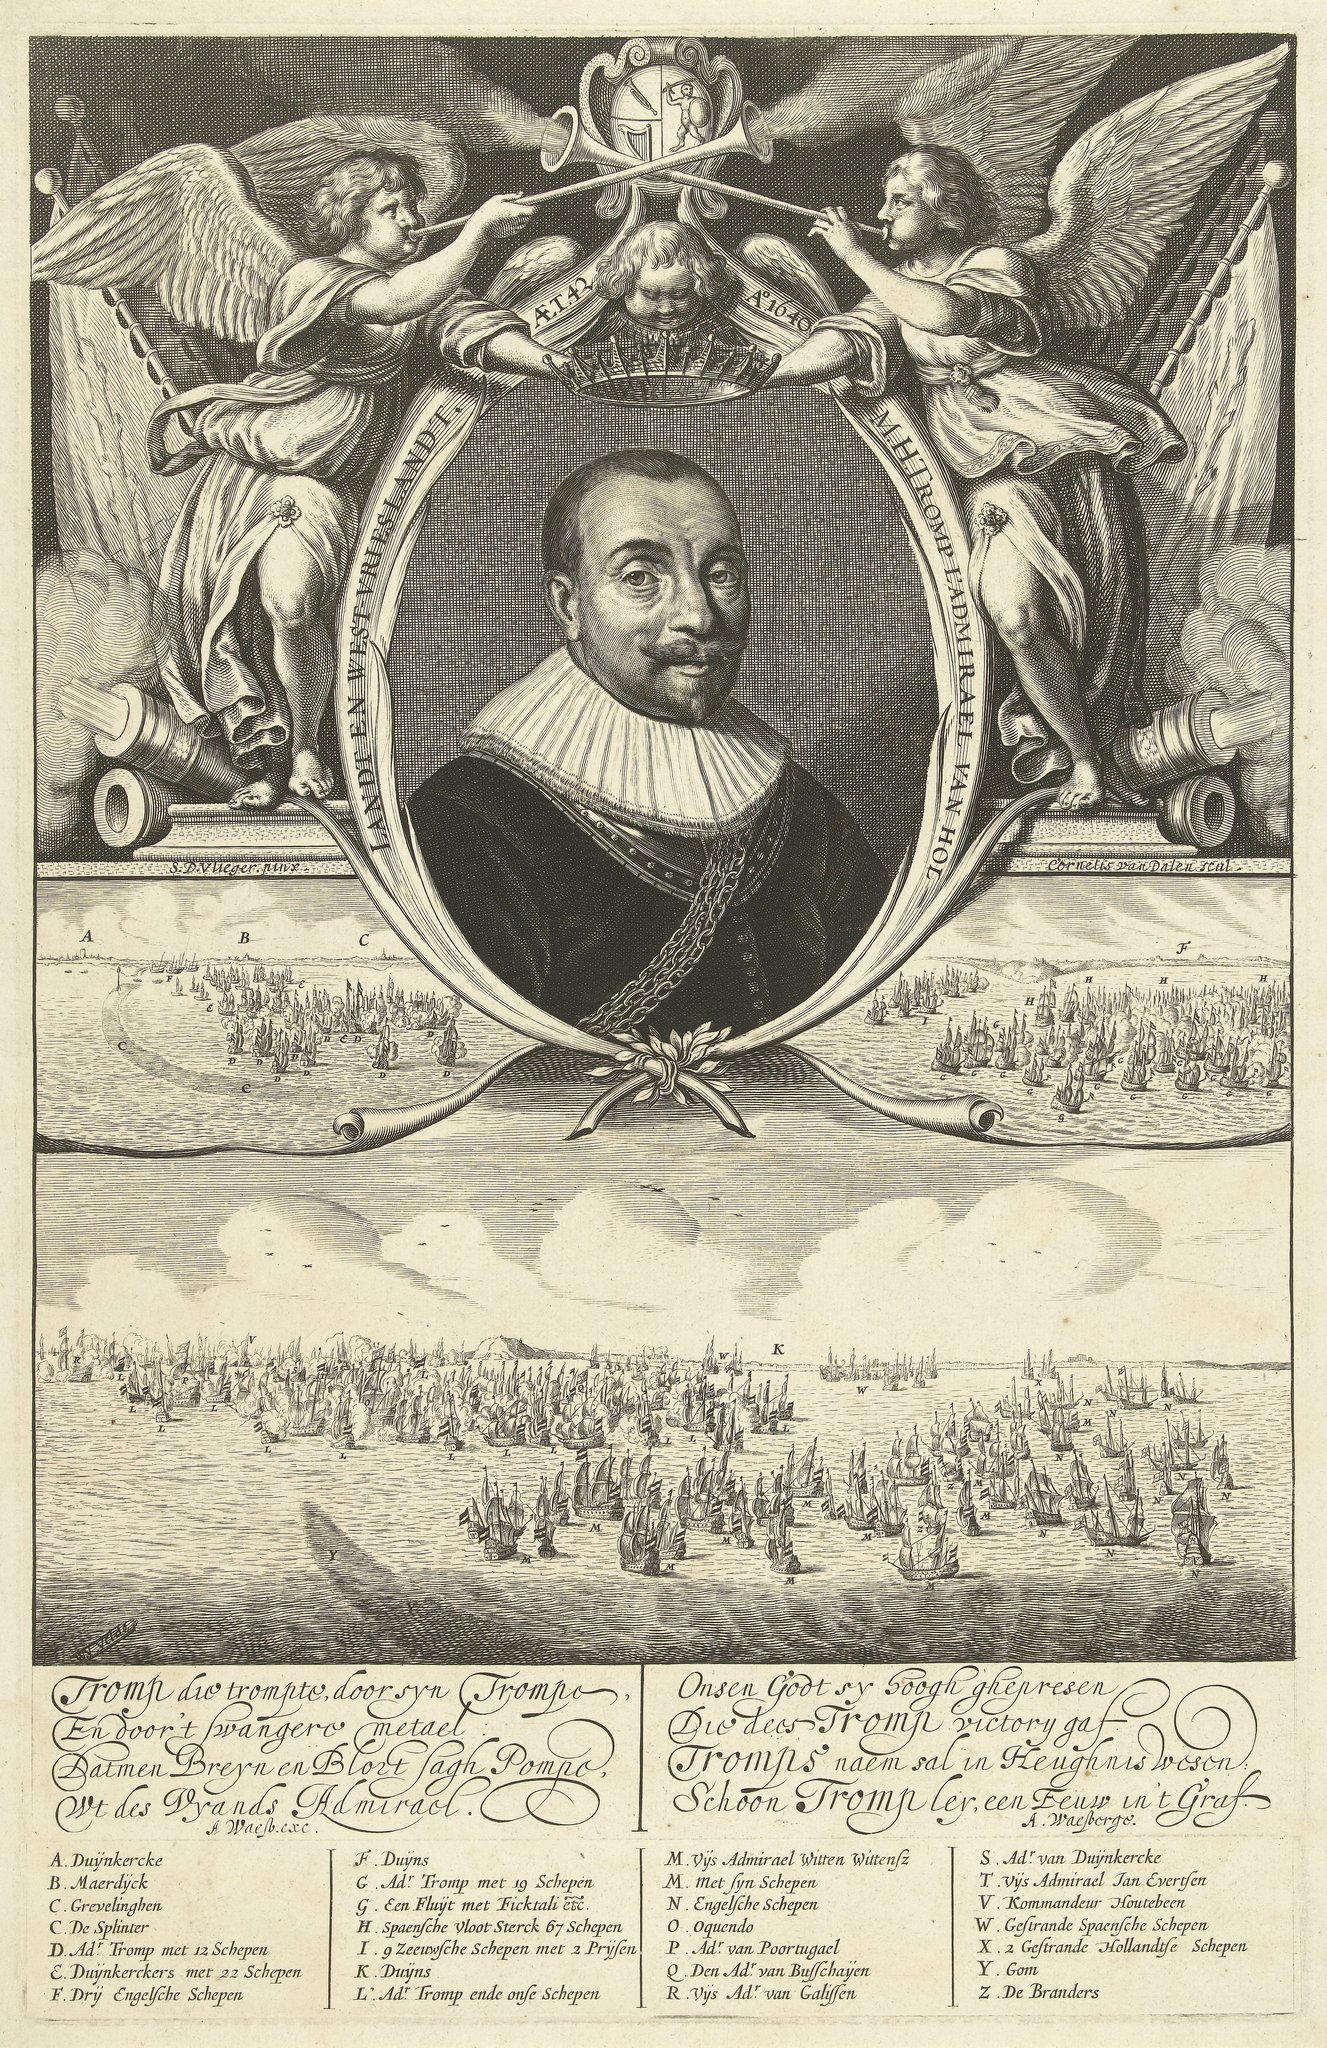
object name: print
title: M.H. Tromp L'admirael van Hollandt en West-Vrieslandt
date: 1640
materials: paper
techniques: engraving, etching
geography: amsterdam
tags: brielle, maarten harpertszoon tromp, commander-in-chief, admiral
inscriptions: collector's mark: Lugt 2228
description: Portret van admiraal Maarten Harpertszoon Tromp op 42-jarige leeftijd. Borststuk in ovale omlijsting geflankeerd door twee engelen die blazen op trompetten en vaandels en rokende kanonnen. Onder het portret een weergave in vogelvluchtperspectief van de zeeslag bij Duinkerken waarin admiraal Tromp een verdienstelijk rol speelde. In de marge onder een Nederlands vers in acht regels waarmee Abraham van Waesberge Tromp's goede daden eert. Met een kleine tweede plaat is daaronder nog een lijst gedrukt met verklarende termen met betrekking tot de zeeslag.